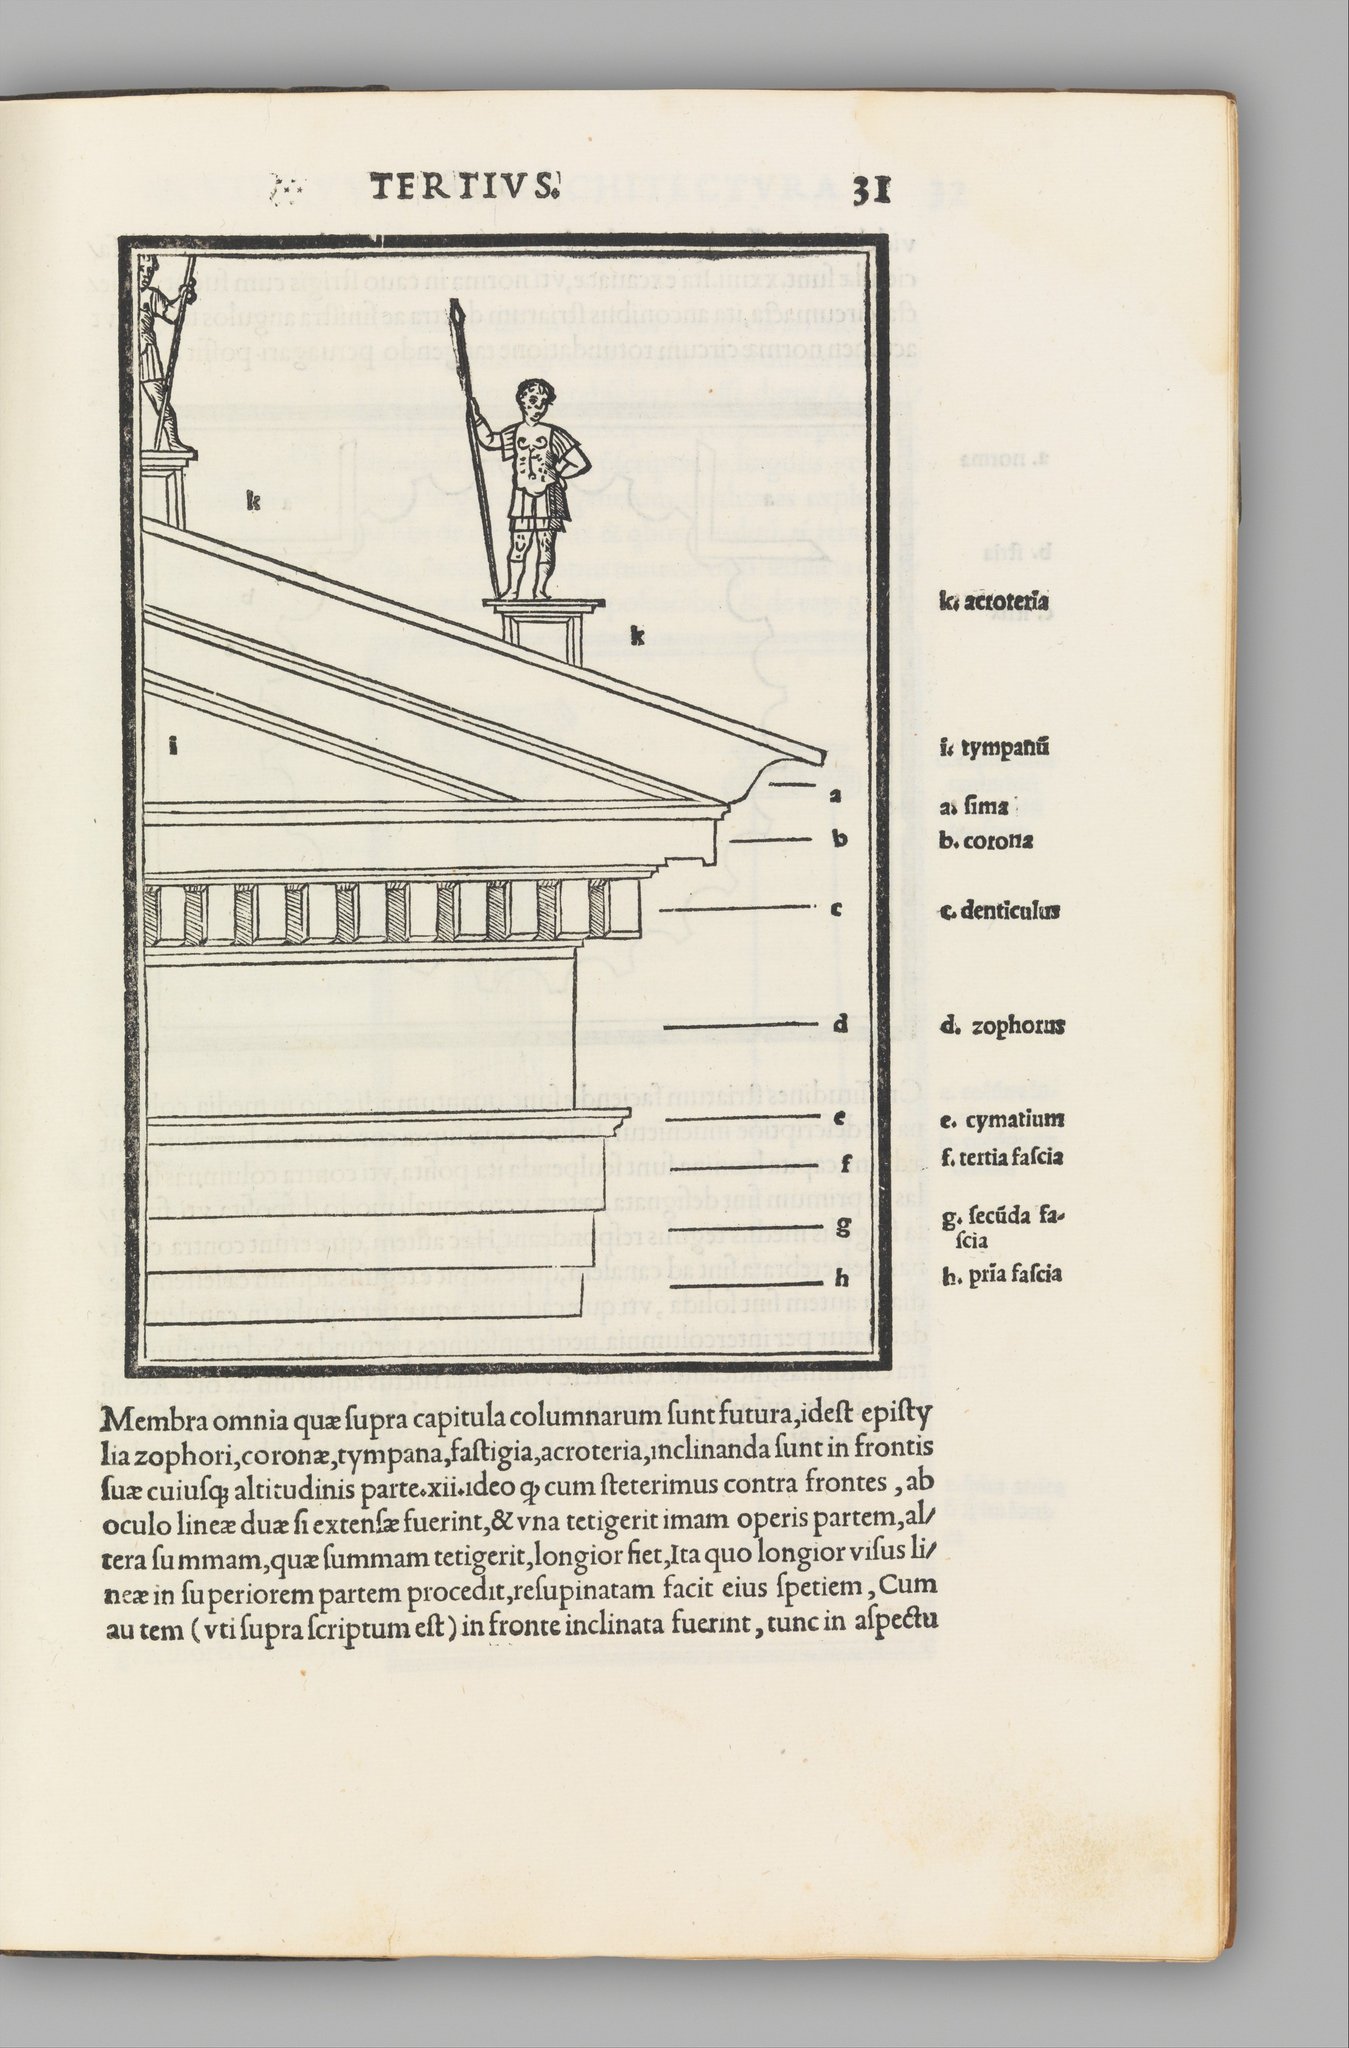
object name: book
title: M. Vitruvius per Iocundum solito castigatior factus cum figuris et tabula ut iam legi et intelligi possit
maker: marcus pollio vitruvius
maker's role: author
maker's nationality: italian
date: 1511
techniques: printing, woodcut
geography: italy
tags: architecture